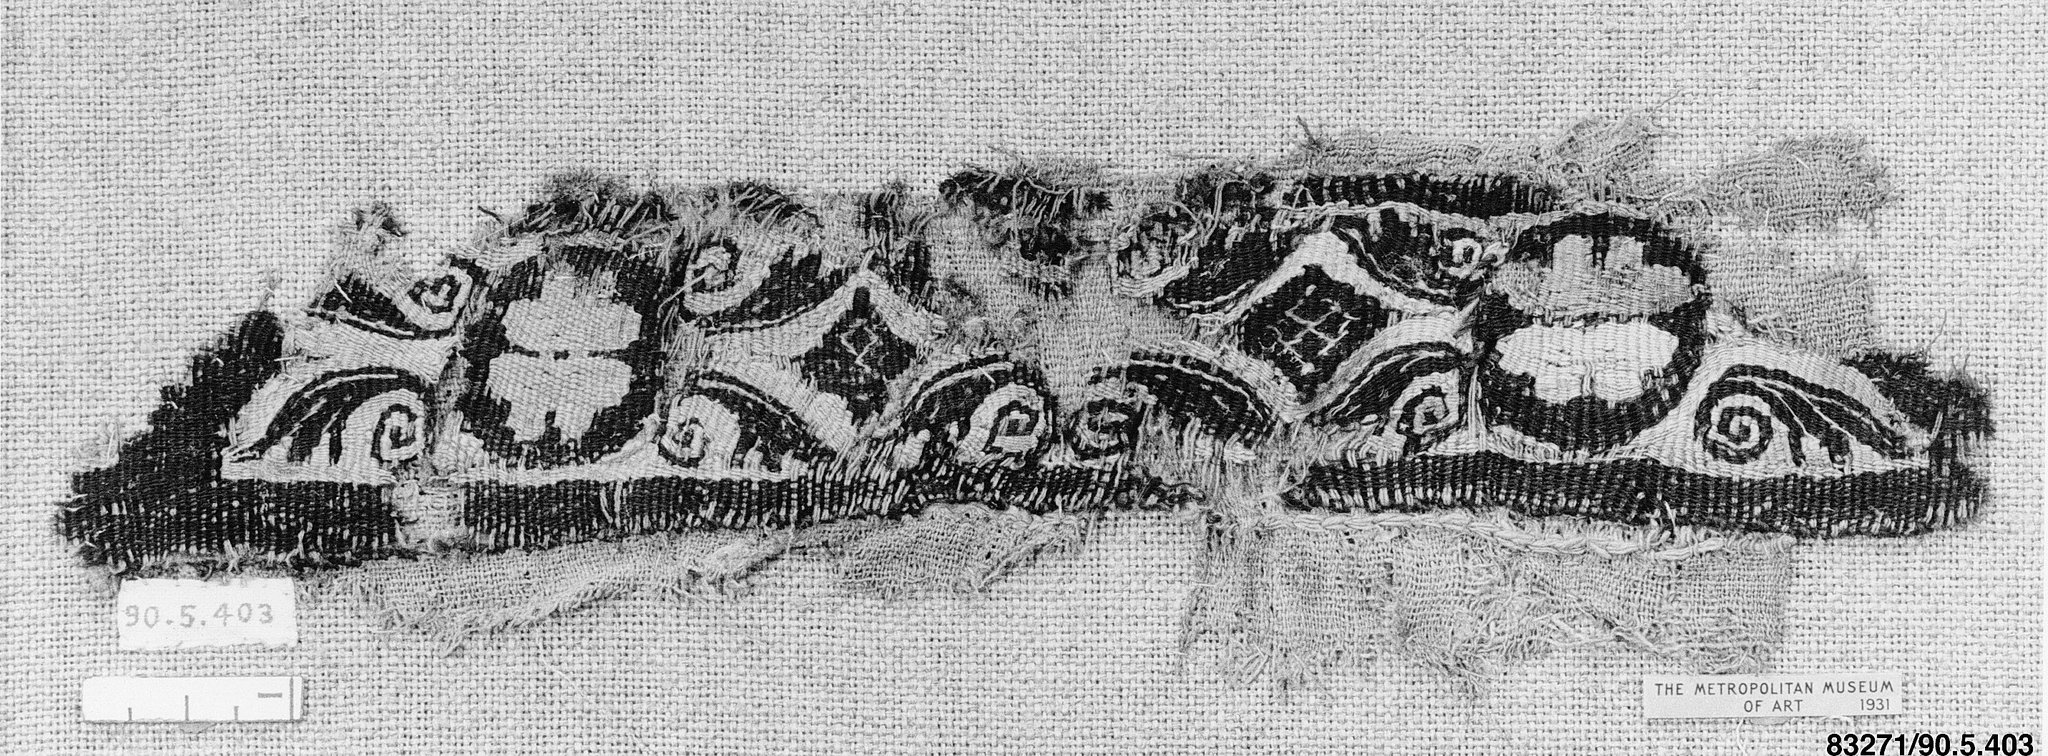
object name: textile fragment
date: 201-400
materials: linen, wool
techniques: weave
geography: egypt